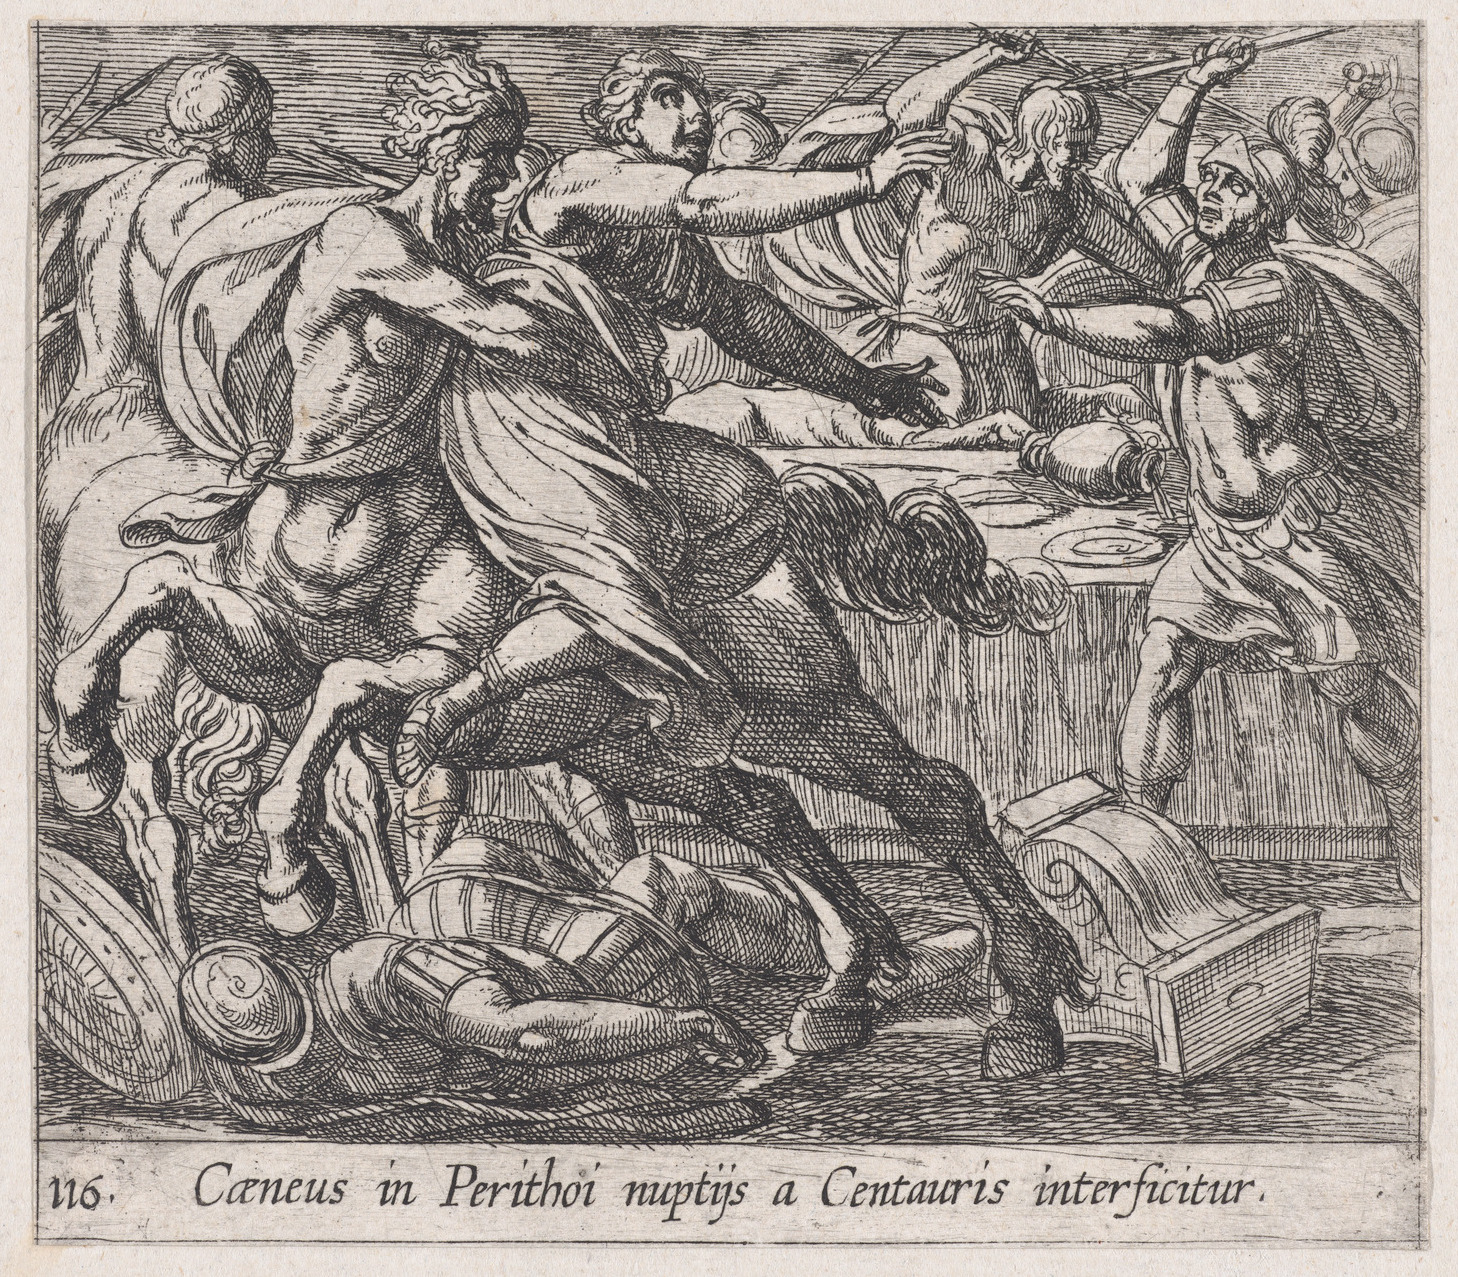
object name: print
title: Plate 116: The Battle of the Lapithae and the Centaurs (Caeneus in Perithoi nuptijs a Centauris interficitur), from Ovid's 'Metamorphoses'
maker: antonio tempesta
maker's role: artist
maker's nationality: italian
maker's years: 1555-1630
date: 1606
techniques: etching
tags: battles,weapons,men,centaurs